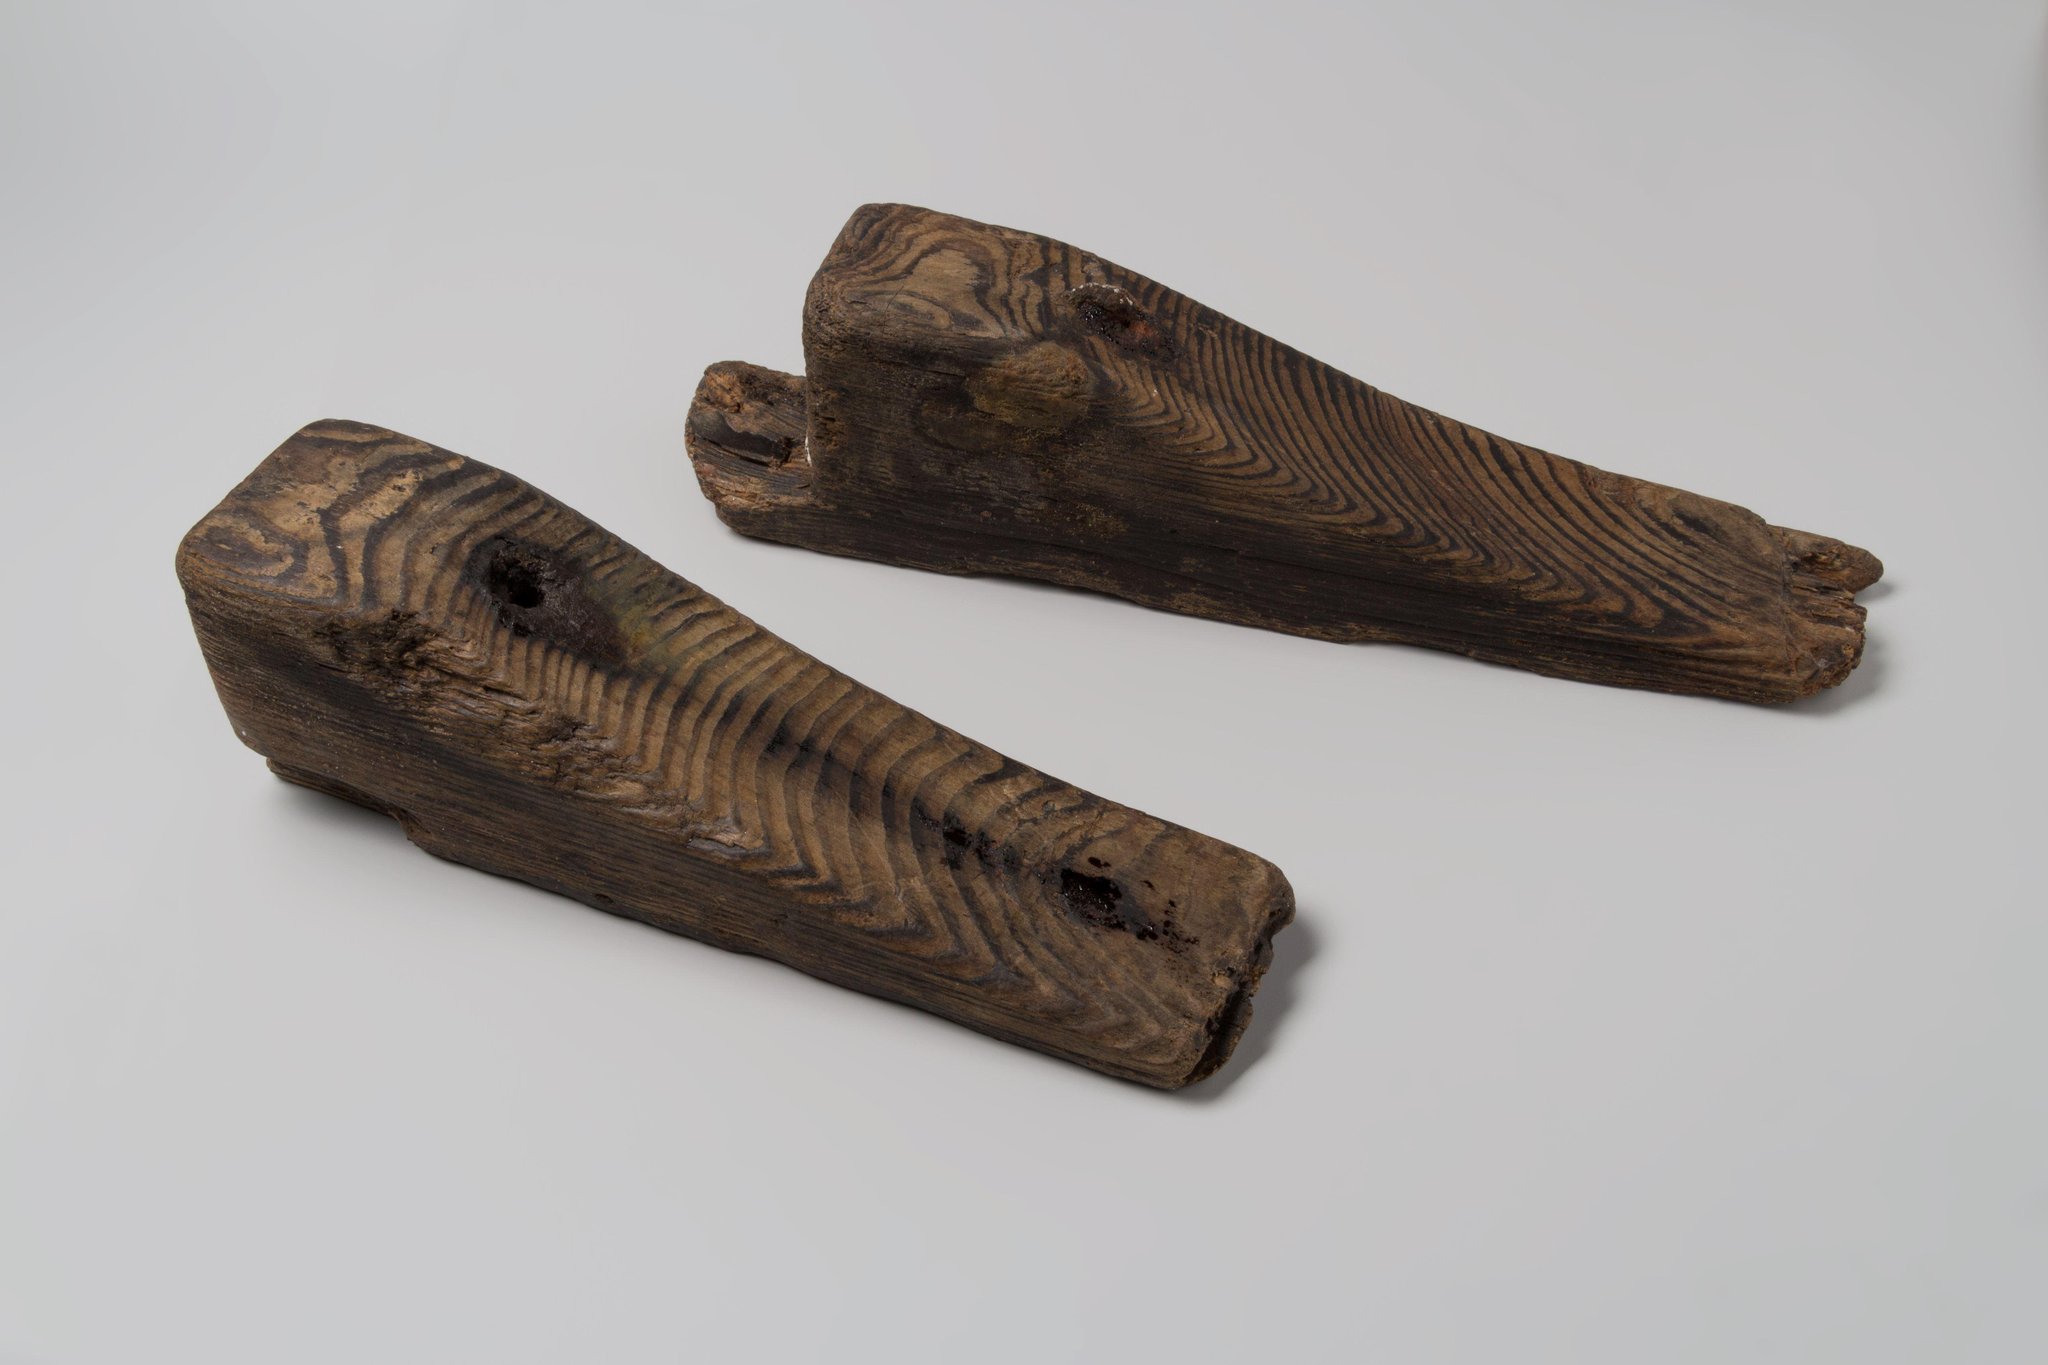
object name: corbel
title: Kraagsteen uit het wrak van de Oost-Indiëvaarder Hollandia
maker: Anonymous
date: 1700-1743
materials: wood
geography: netherlands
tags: verenigde oostindische compagnie, hollandia (schip), annet